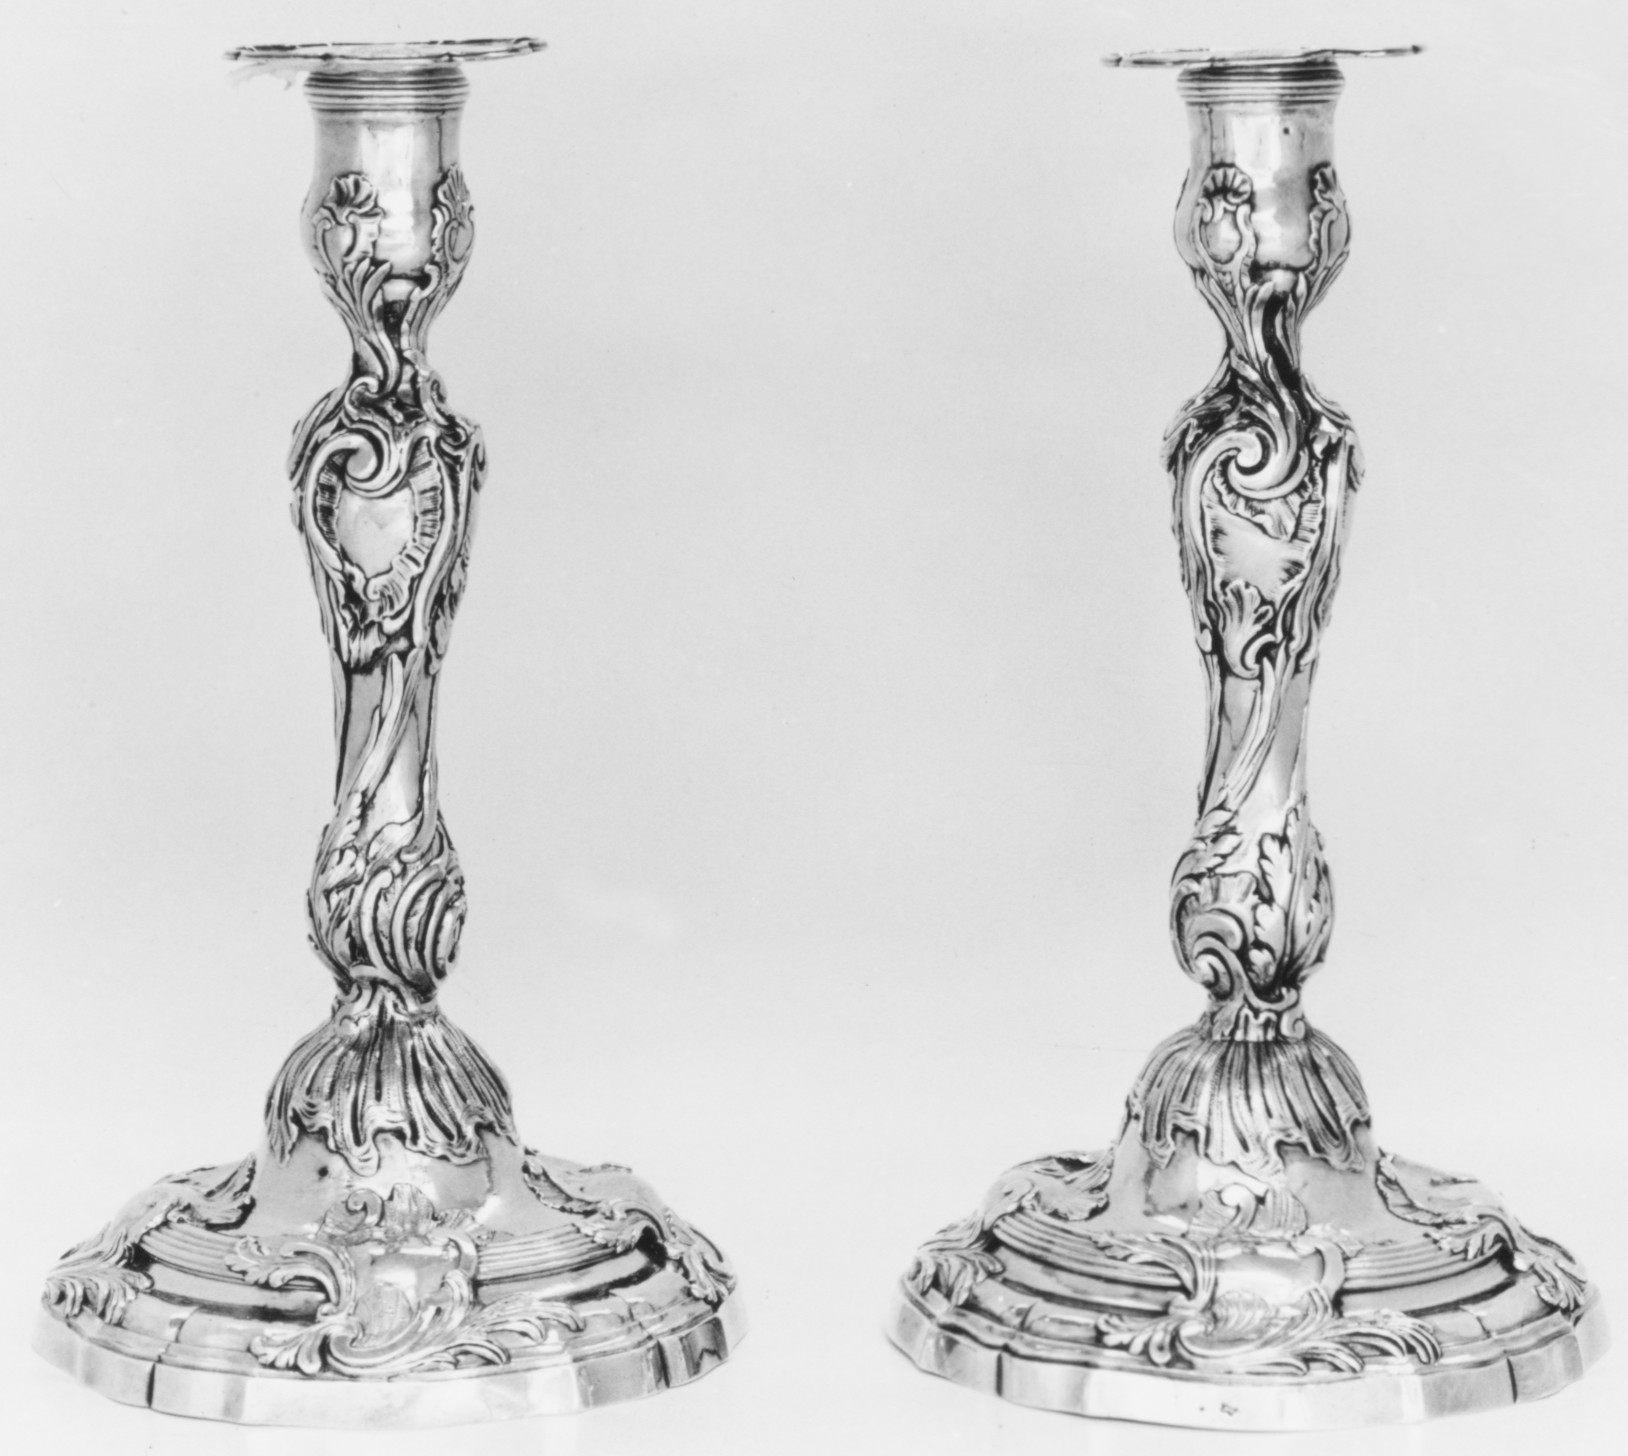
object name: candlestick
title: Candlestick (one of a pair)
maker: michel ii delapierre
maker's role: maker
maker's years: 1707-1815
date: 1747-1749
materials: silver